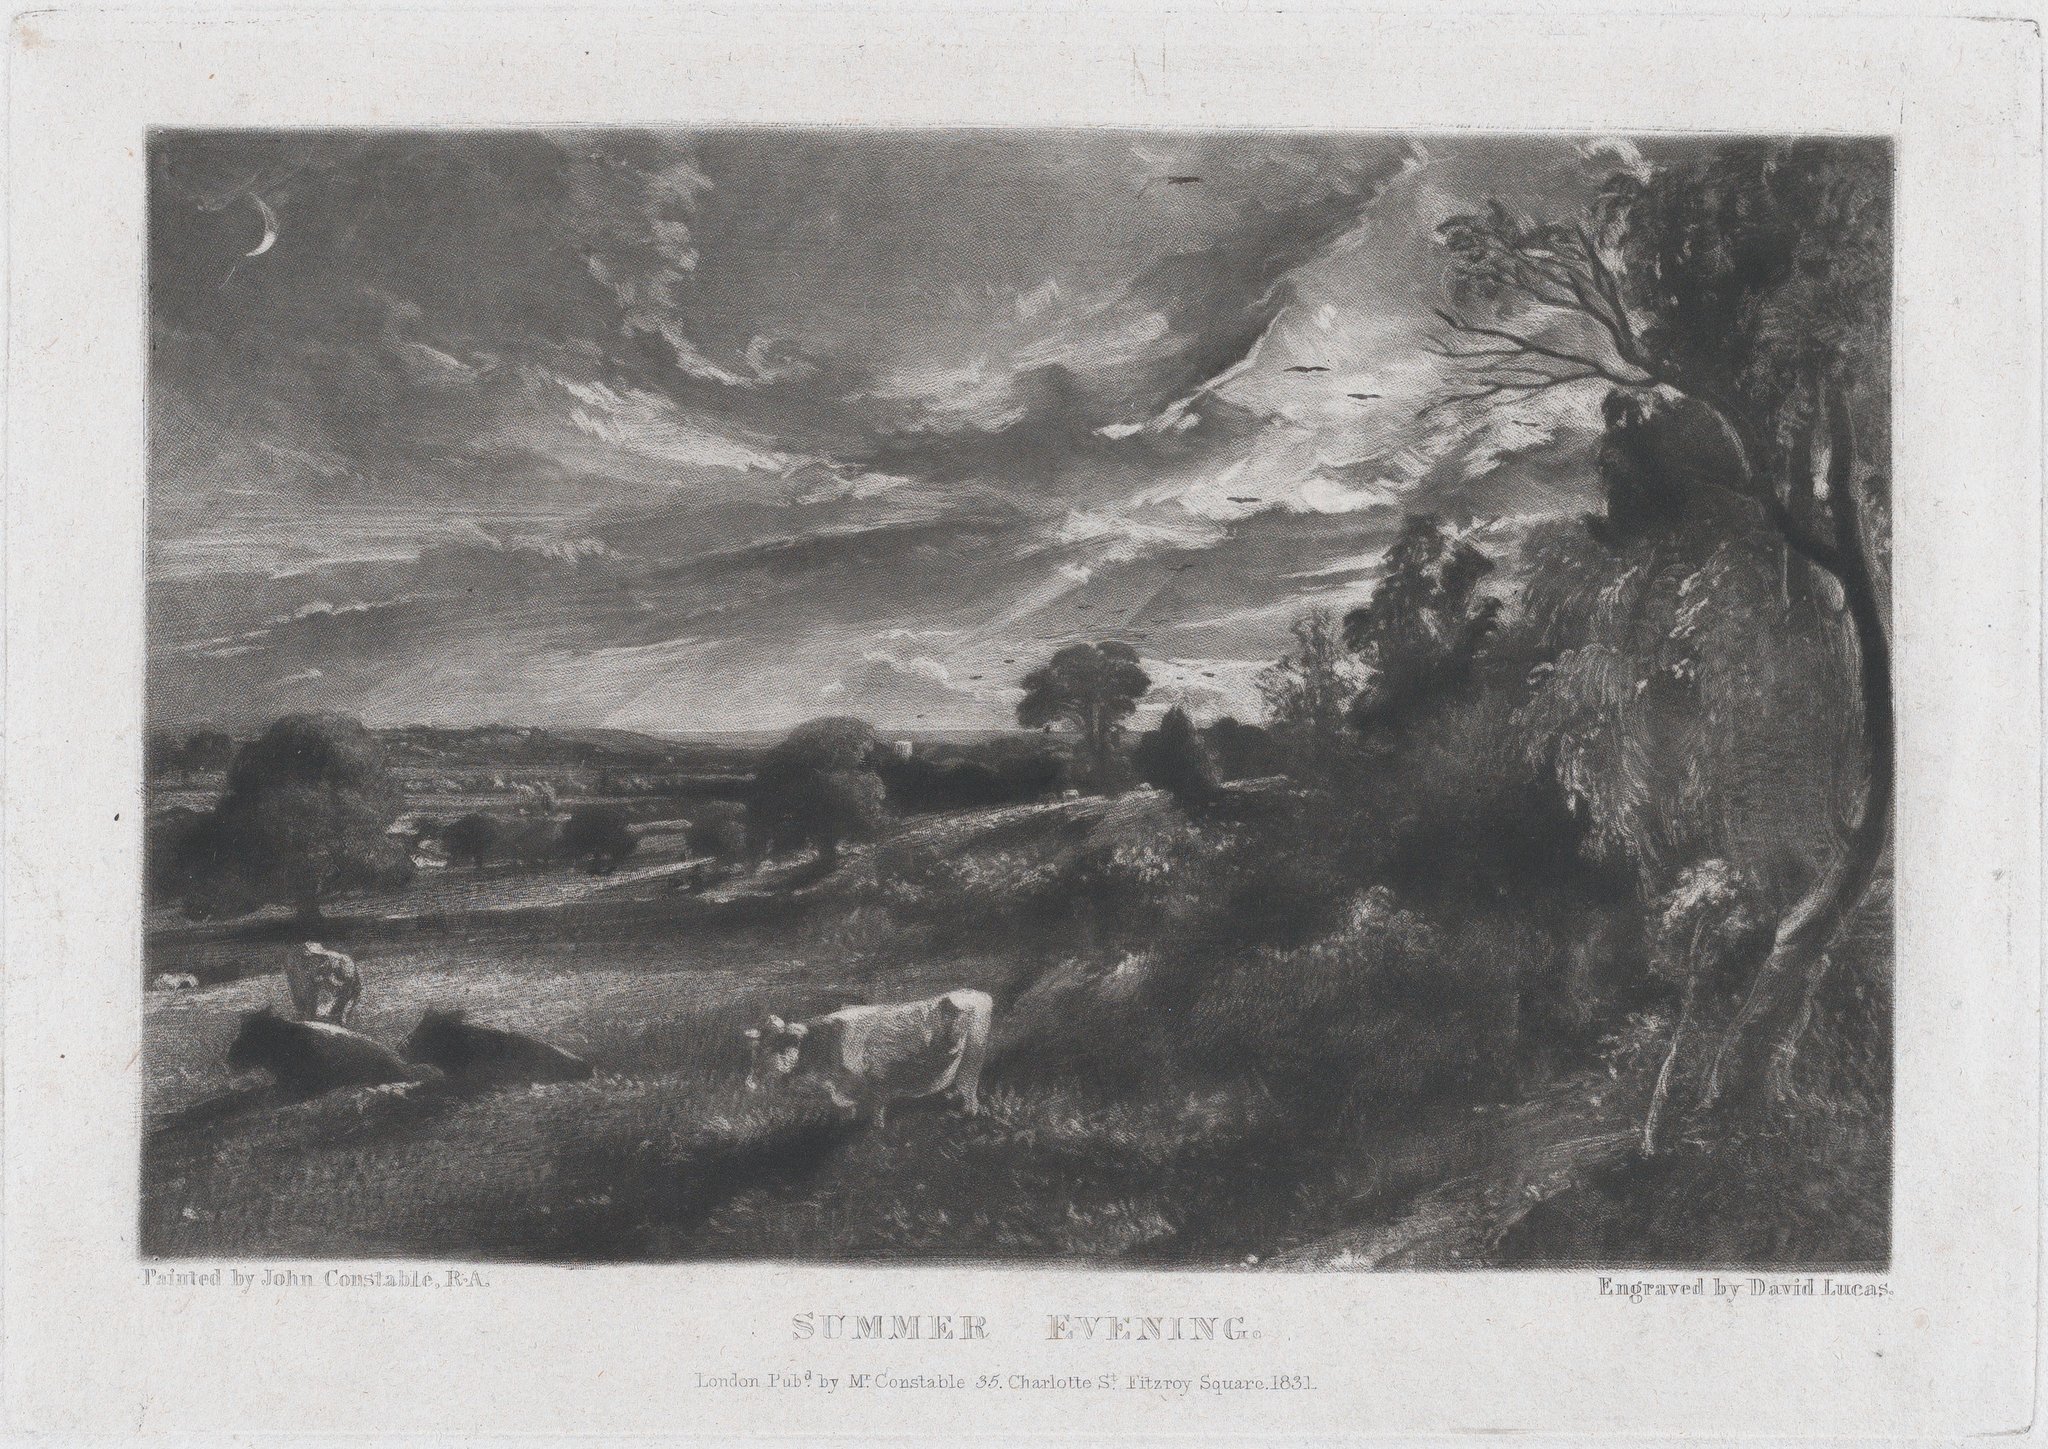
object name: print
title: Summer Evening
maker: david lucas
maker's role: artist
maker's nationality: british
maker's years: 1802-1881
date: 1831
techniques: mezzotint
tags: cows,landscapes,evening